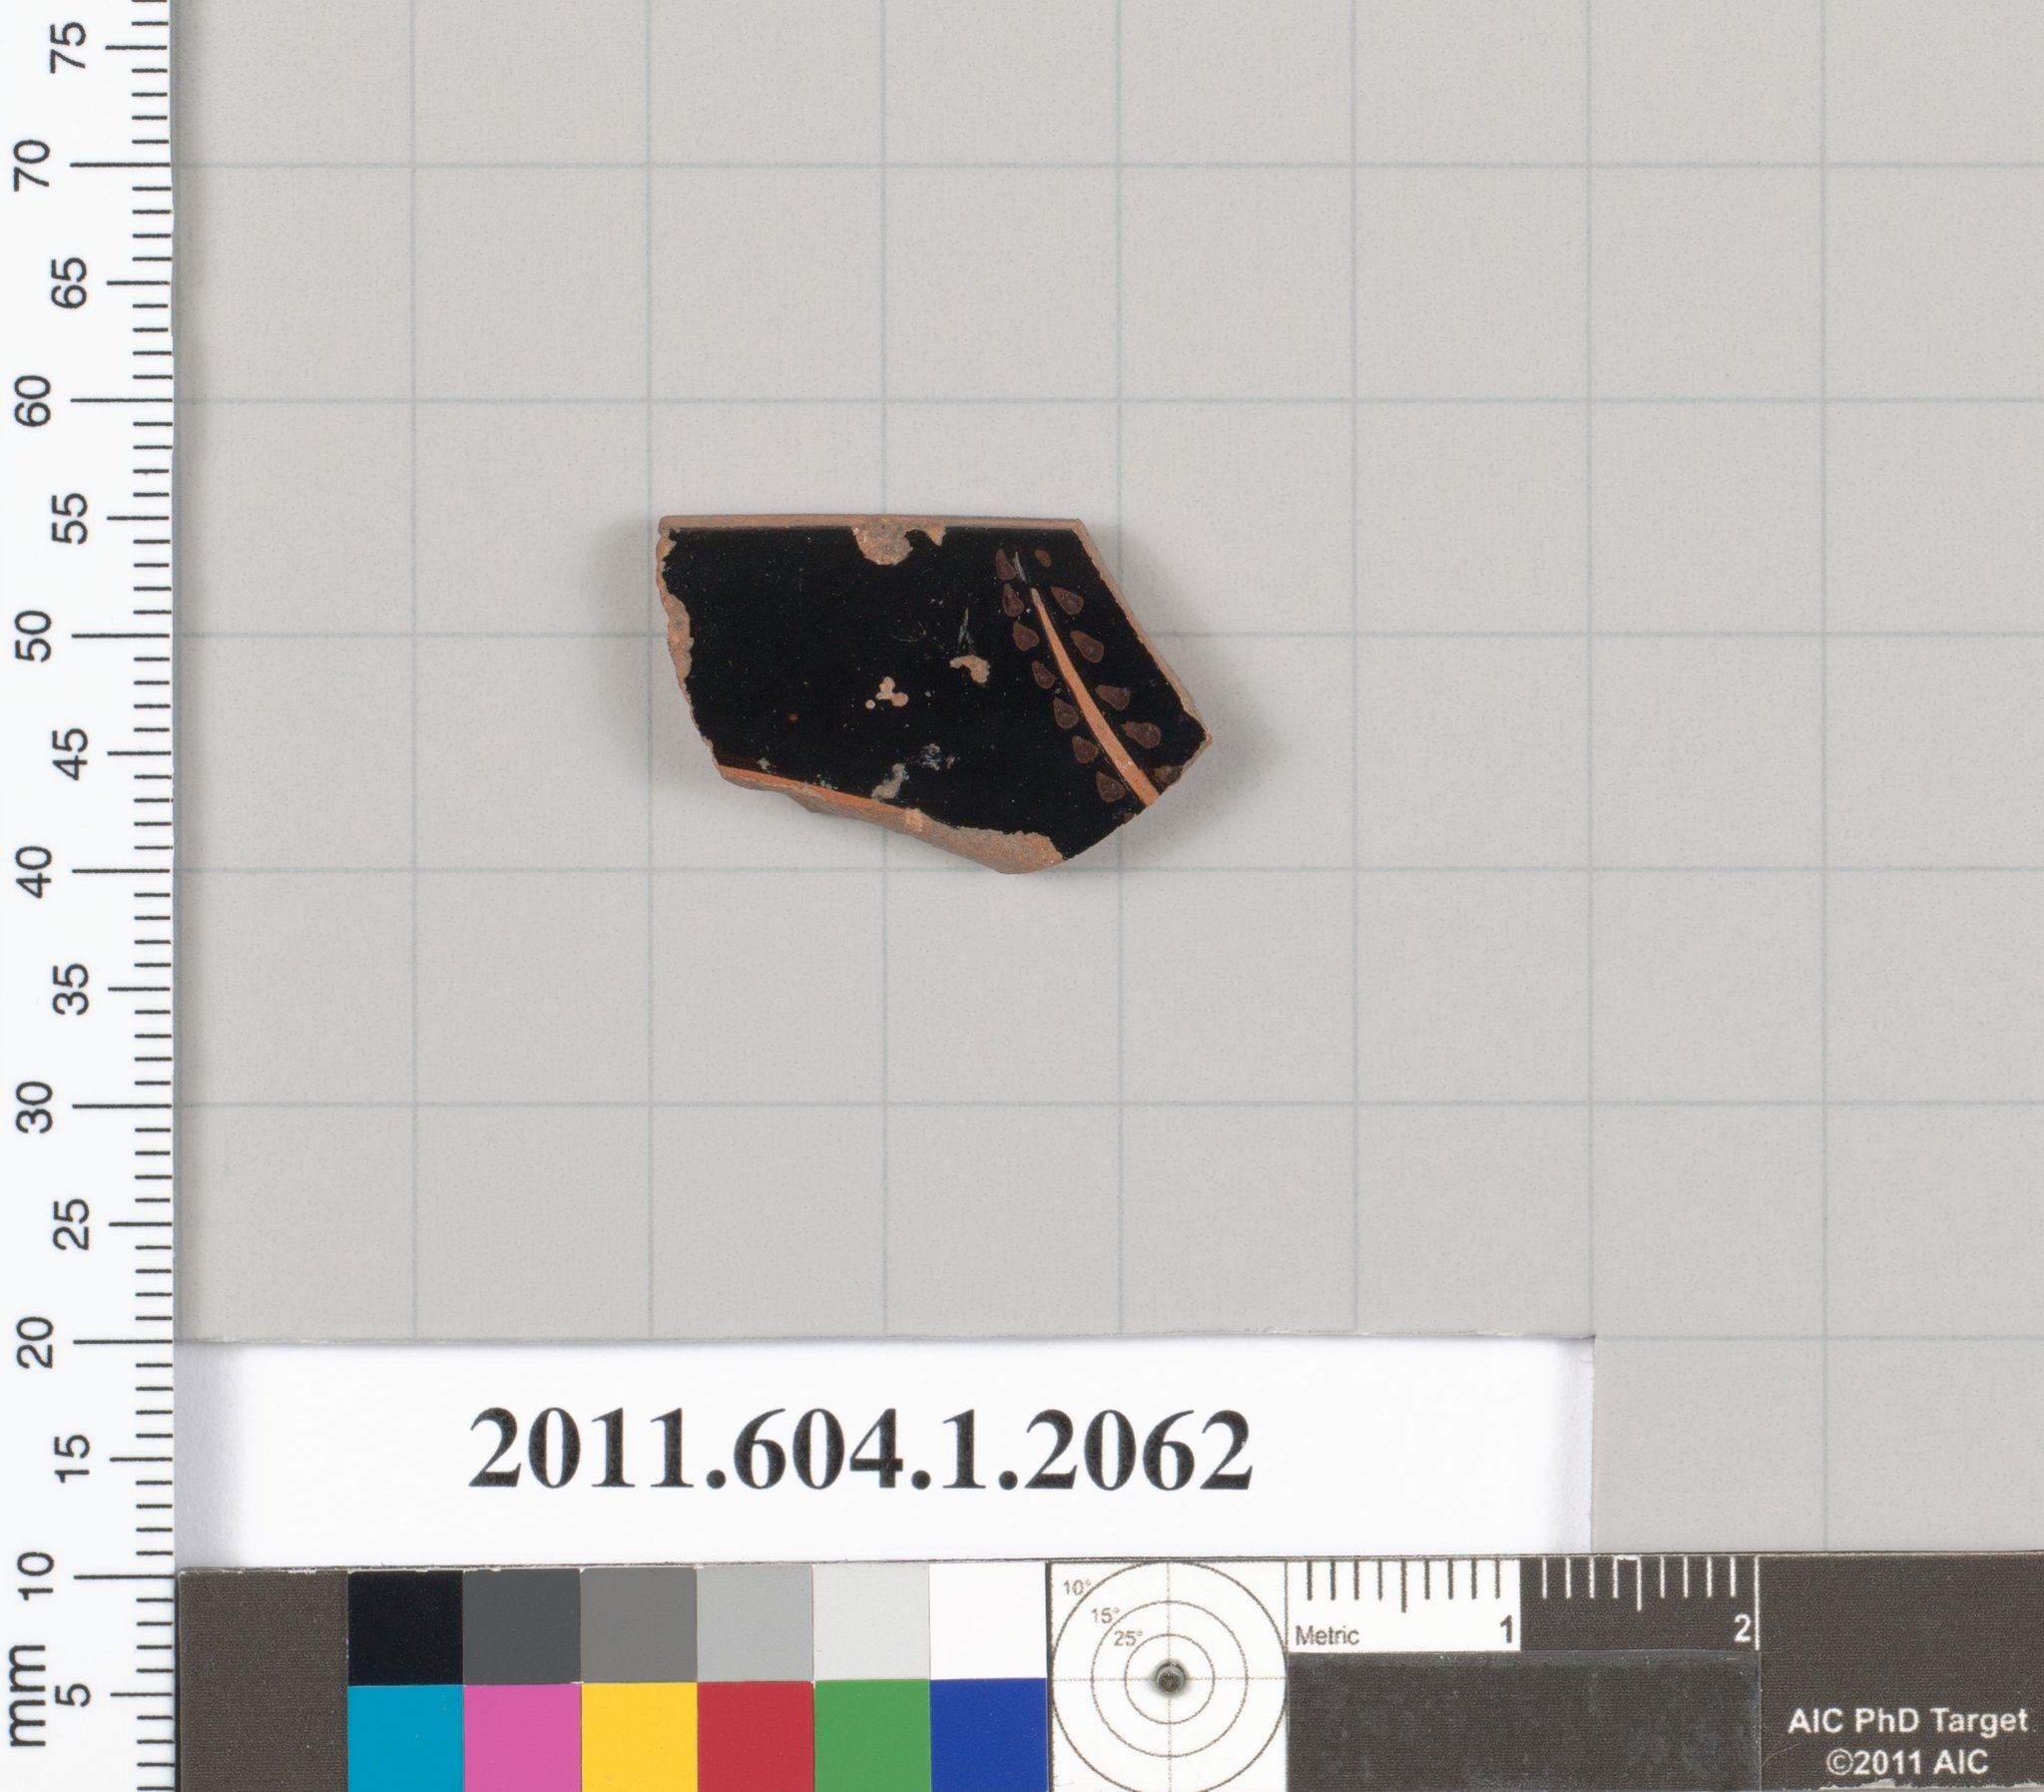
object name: kylix fragment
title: Terracotta rim fragment of a kylix (drinking cup)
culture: greek, attic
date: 490-480 BCE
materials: terracotta